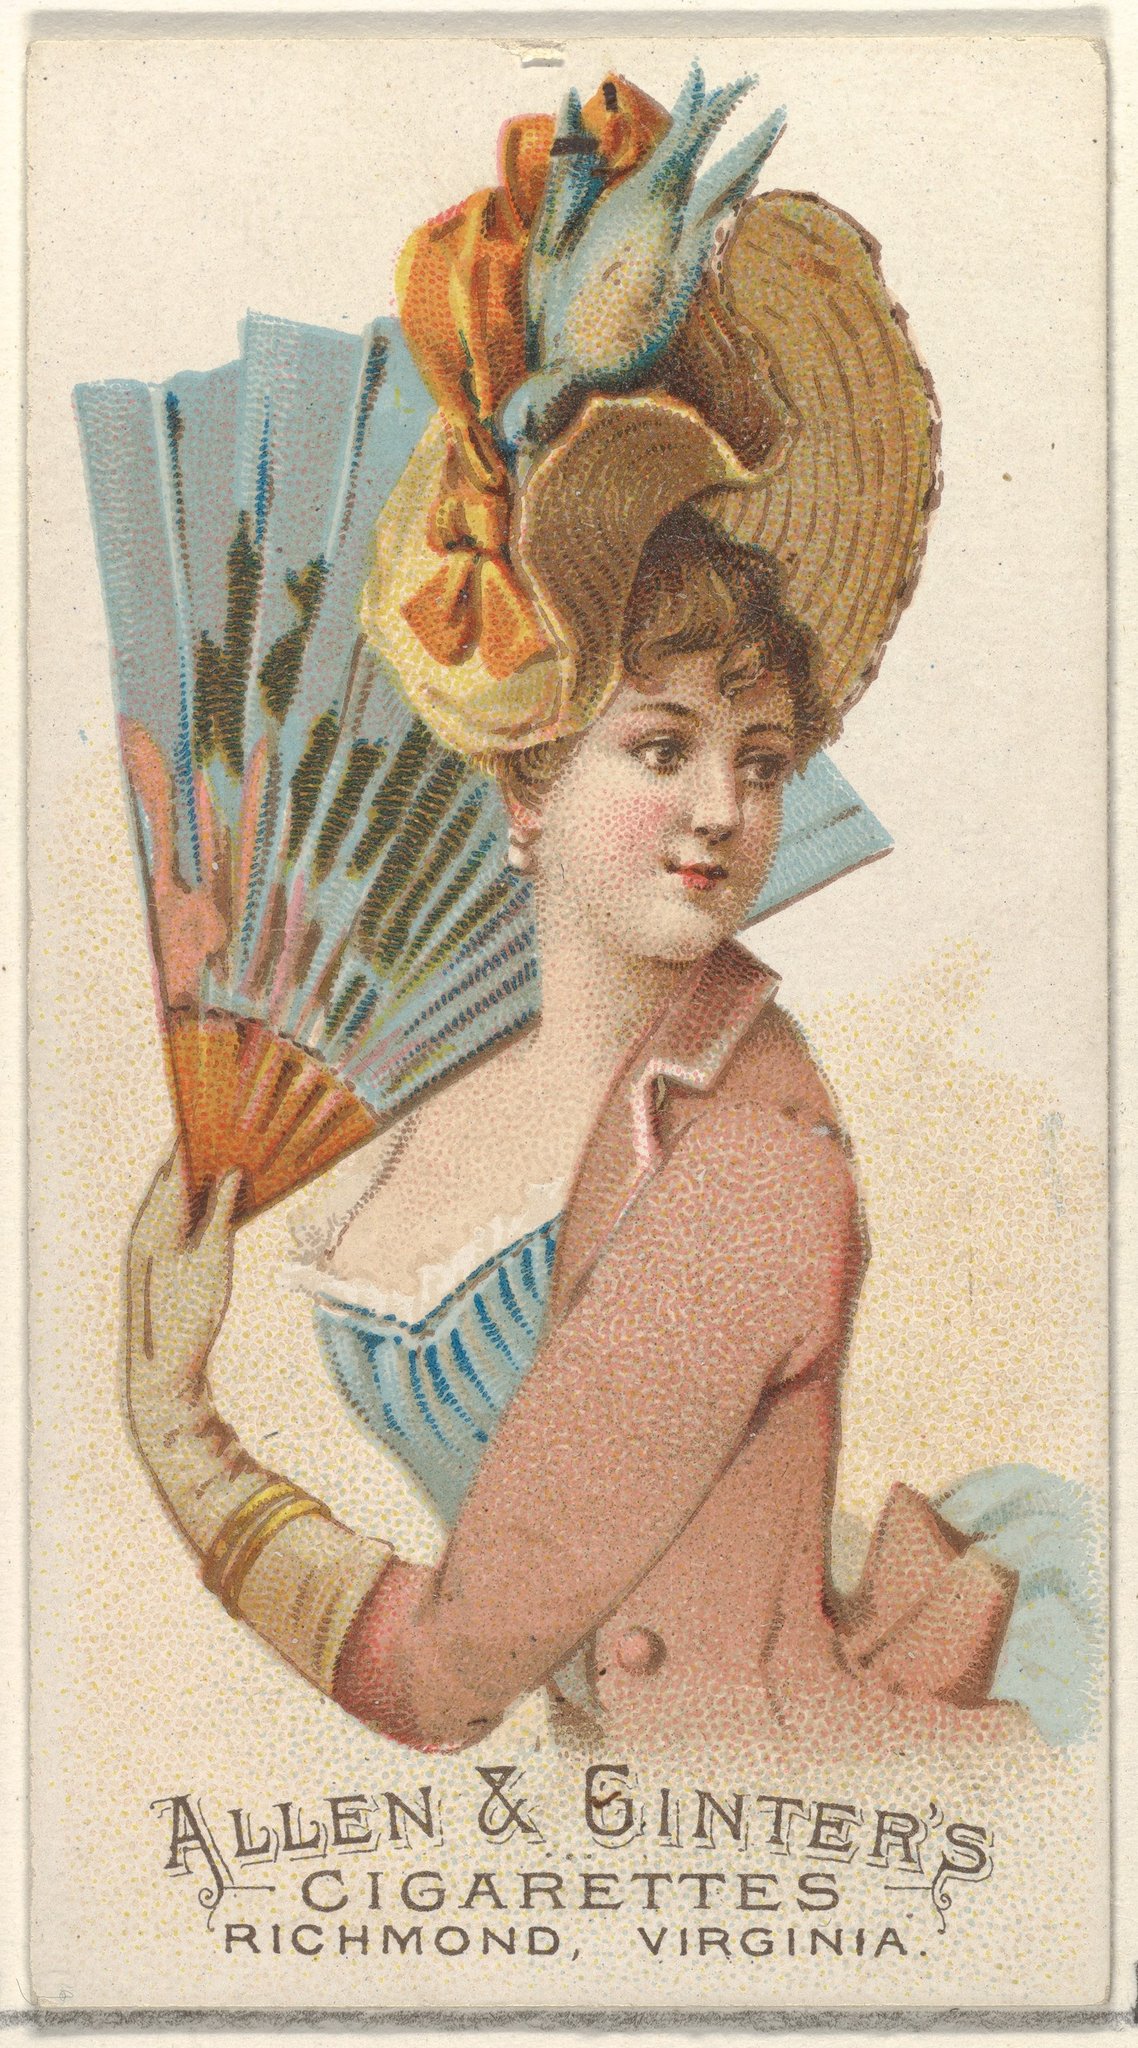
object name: print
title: Plate 38, from the Fans of the Period series (N7) for Allen & Ginter Cigarettes Brands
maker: allen & ginter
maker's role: publisher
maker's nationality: american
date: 1889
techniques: color lithograph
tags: fans,women